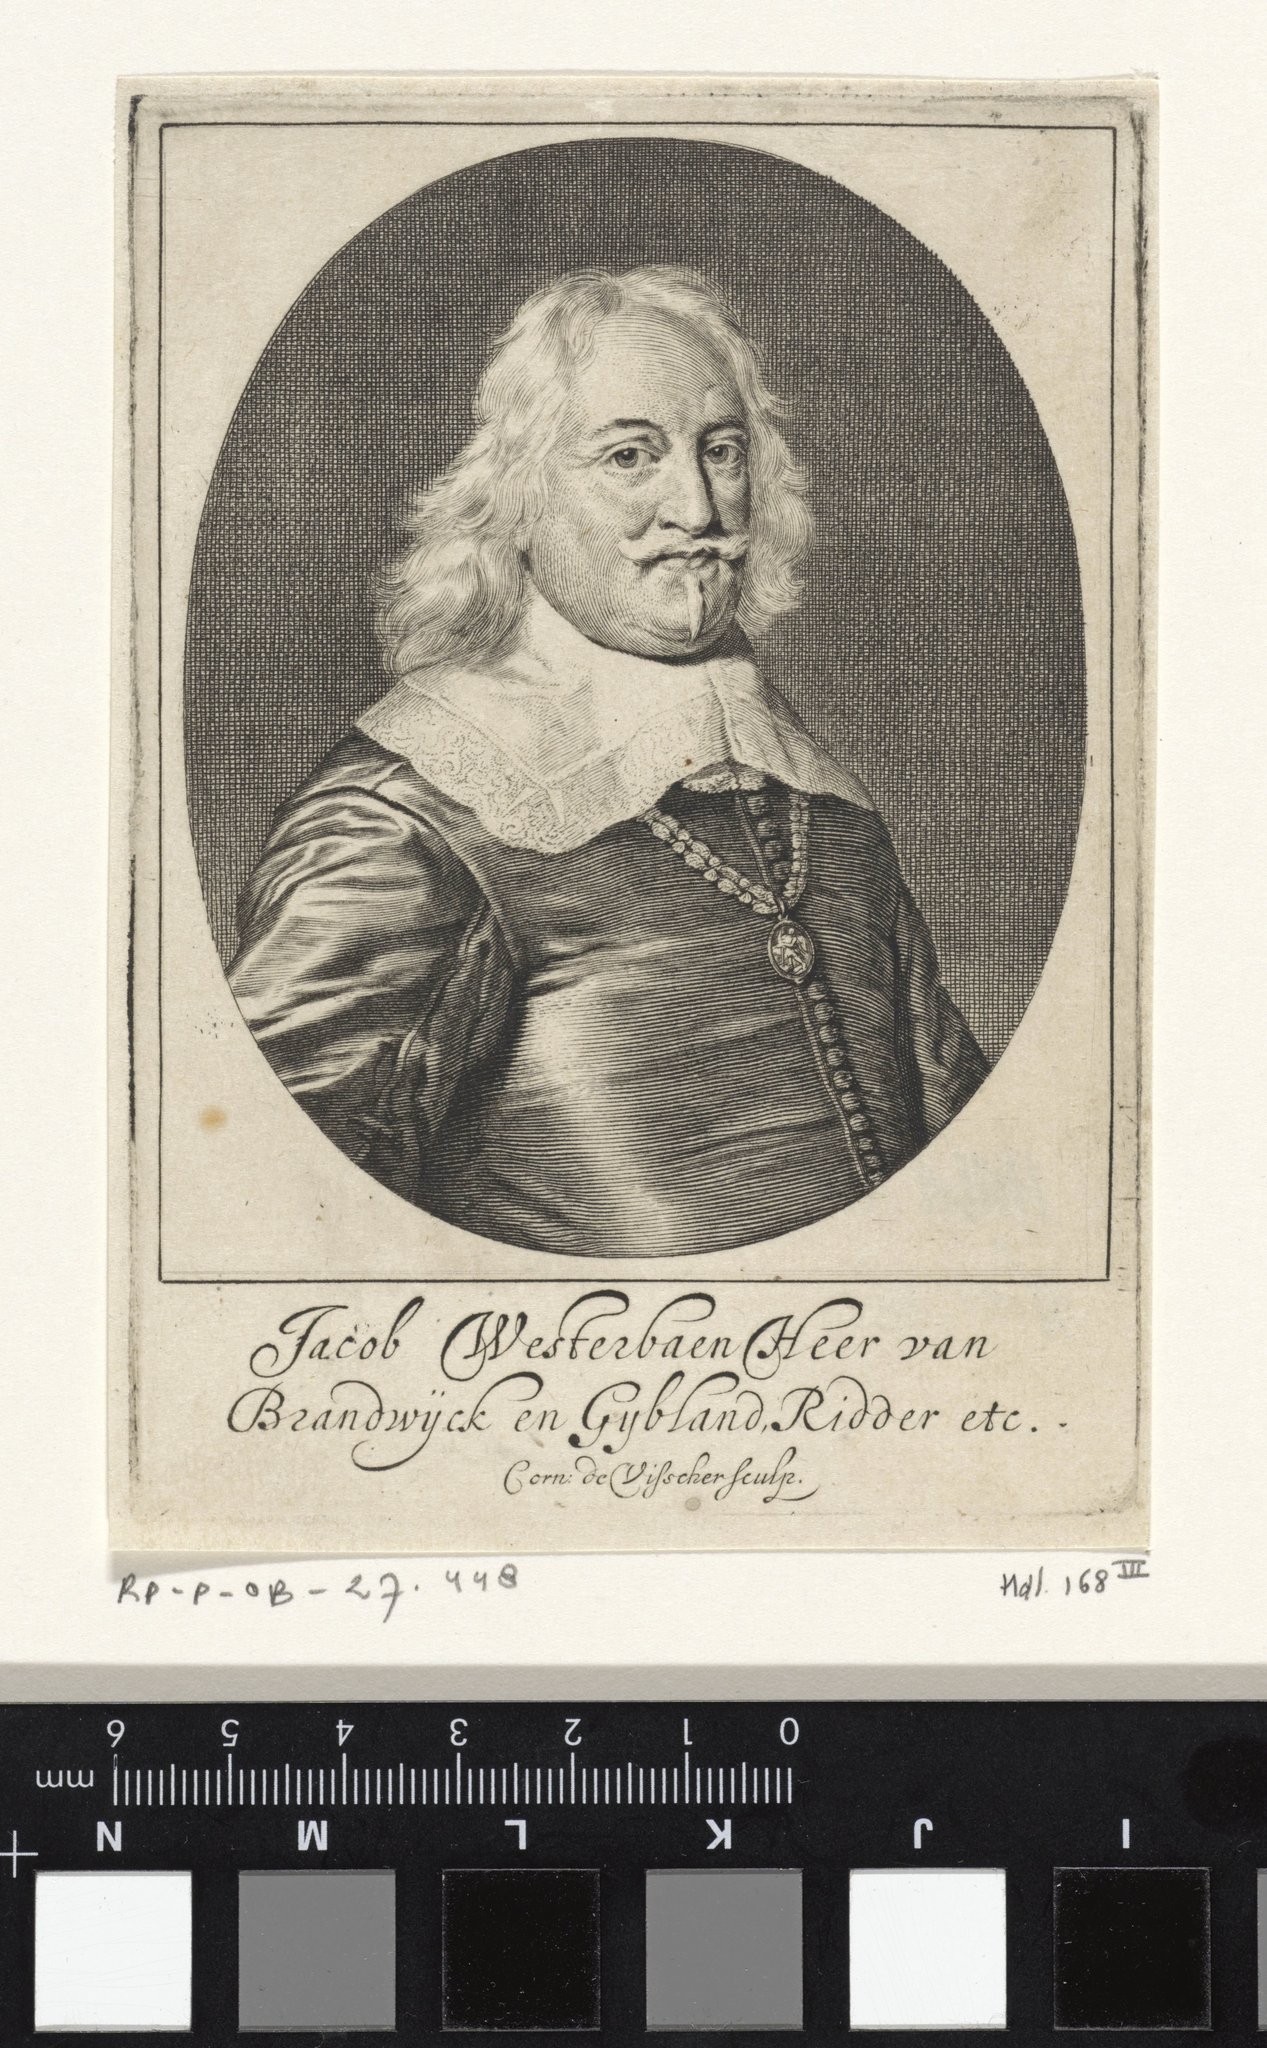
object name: print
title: Portret Jacob Westerbaen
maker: cornelis visscher (ii)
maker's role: draughtsman, painter, print maker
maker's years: 1628-1658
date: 1638-1658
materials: paper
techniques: engraving